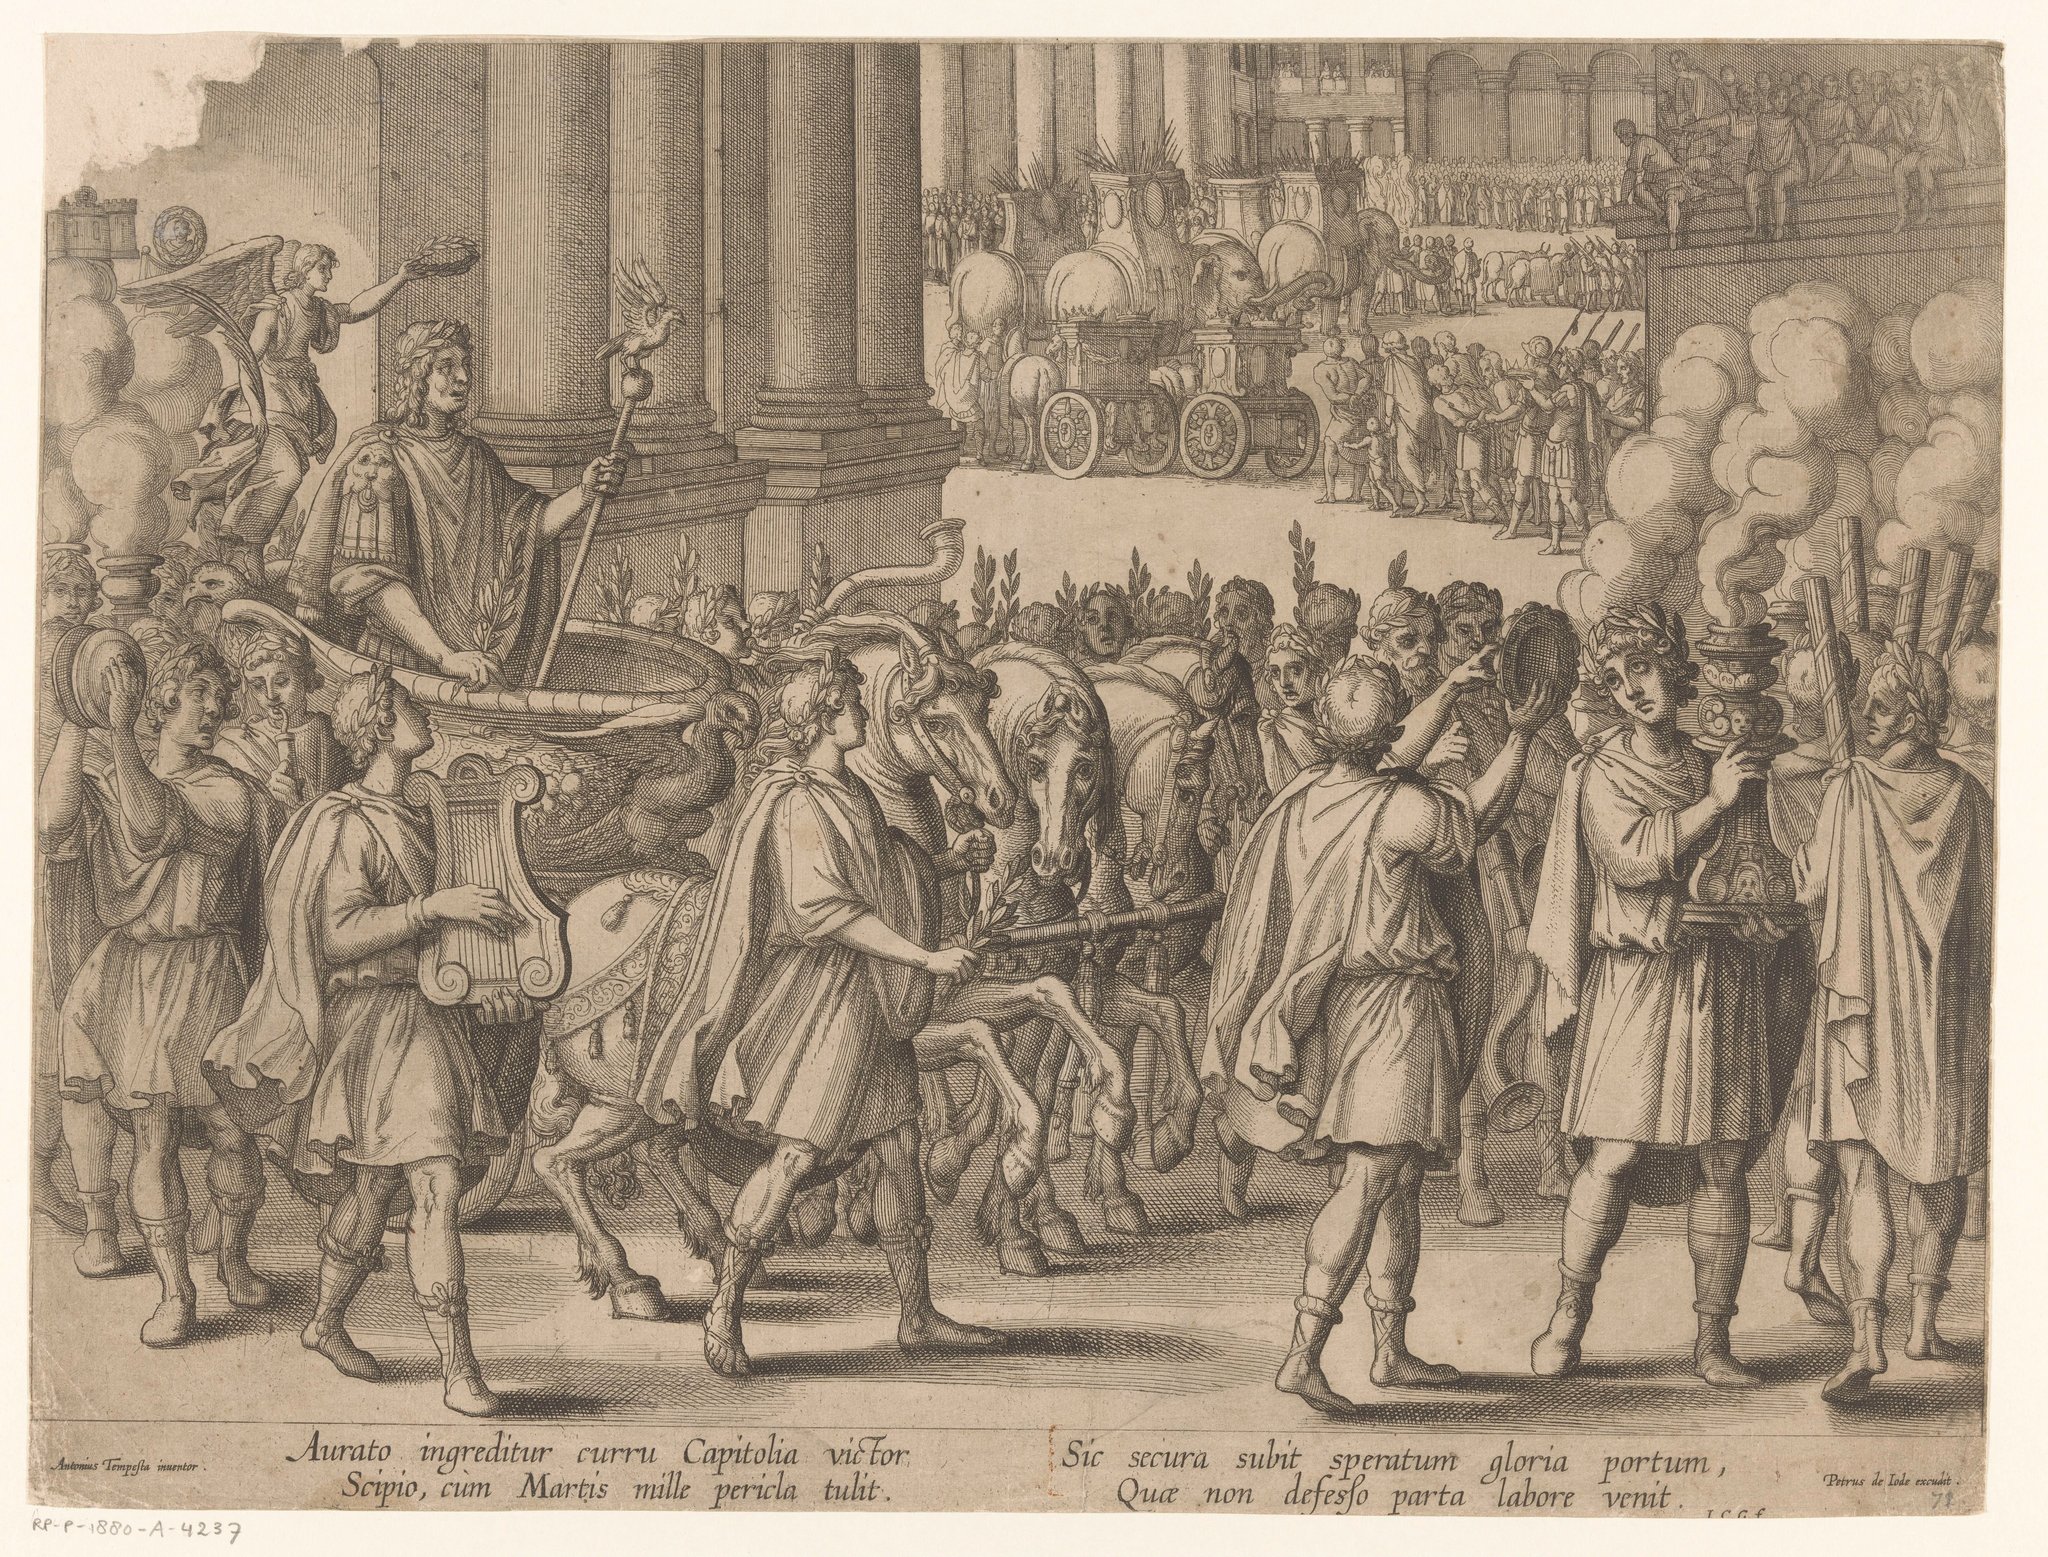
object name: print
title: Intocht van Scipio Africanus na zijn overwinning op Carthago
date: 1620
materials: paper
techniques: etching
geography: italy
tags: rome, politician, triumph of scipio, triumphal entry and public reception, pageant, 'entrée solennelle', 'joyeuse entrée', (story of) p. cornelius scipio africanus major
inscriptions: collector's mark: Lugt 2228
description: Een processie van soldaten, gevangenen, olifanten, muzikanten en priesters de stad in. Scipio Africanus op een triomfwagen links. Achter hem zweeft een engel die hem een lauwerkrans boven het hoofd houdt. Versregels in het Latijn in ondermarge.